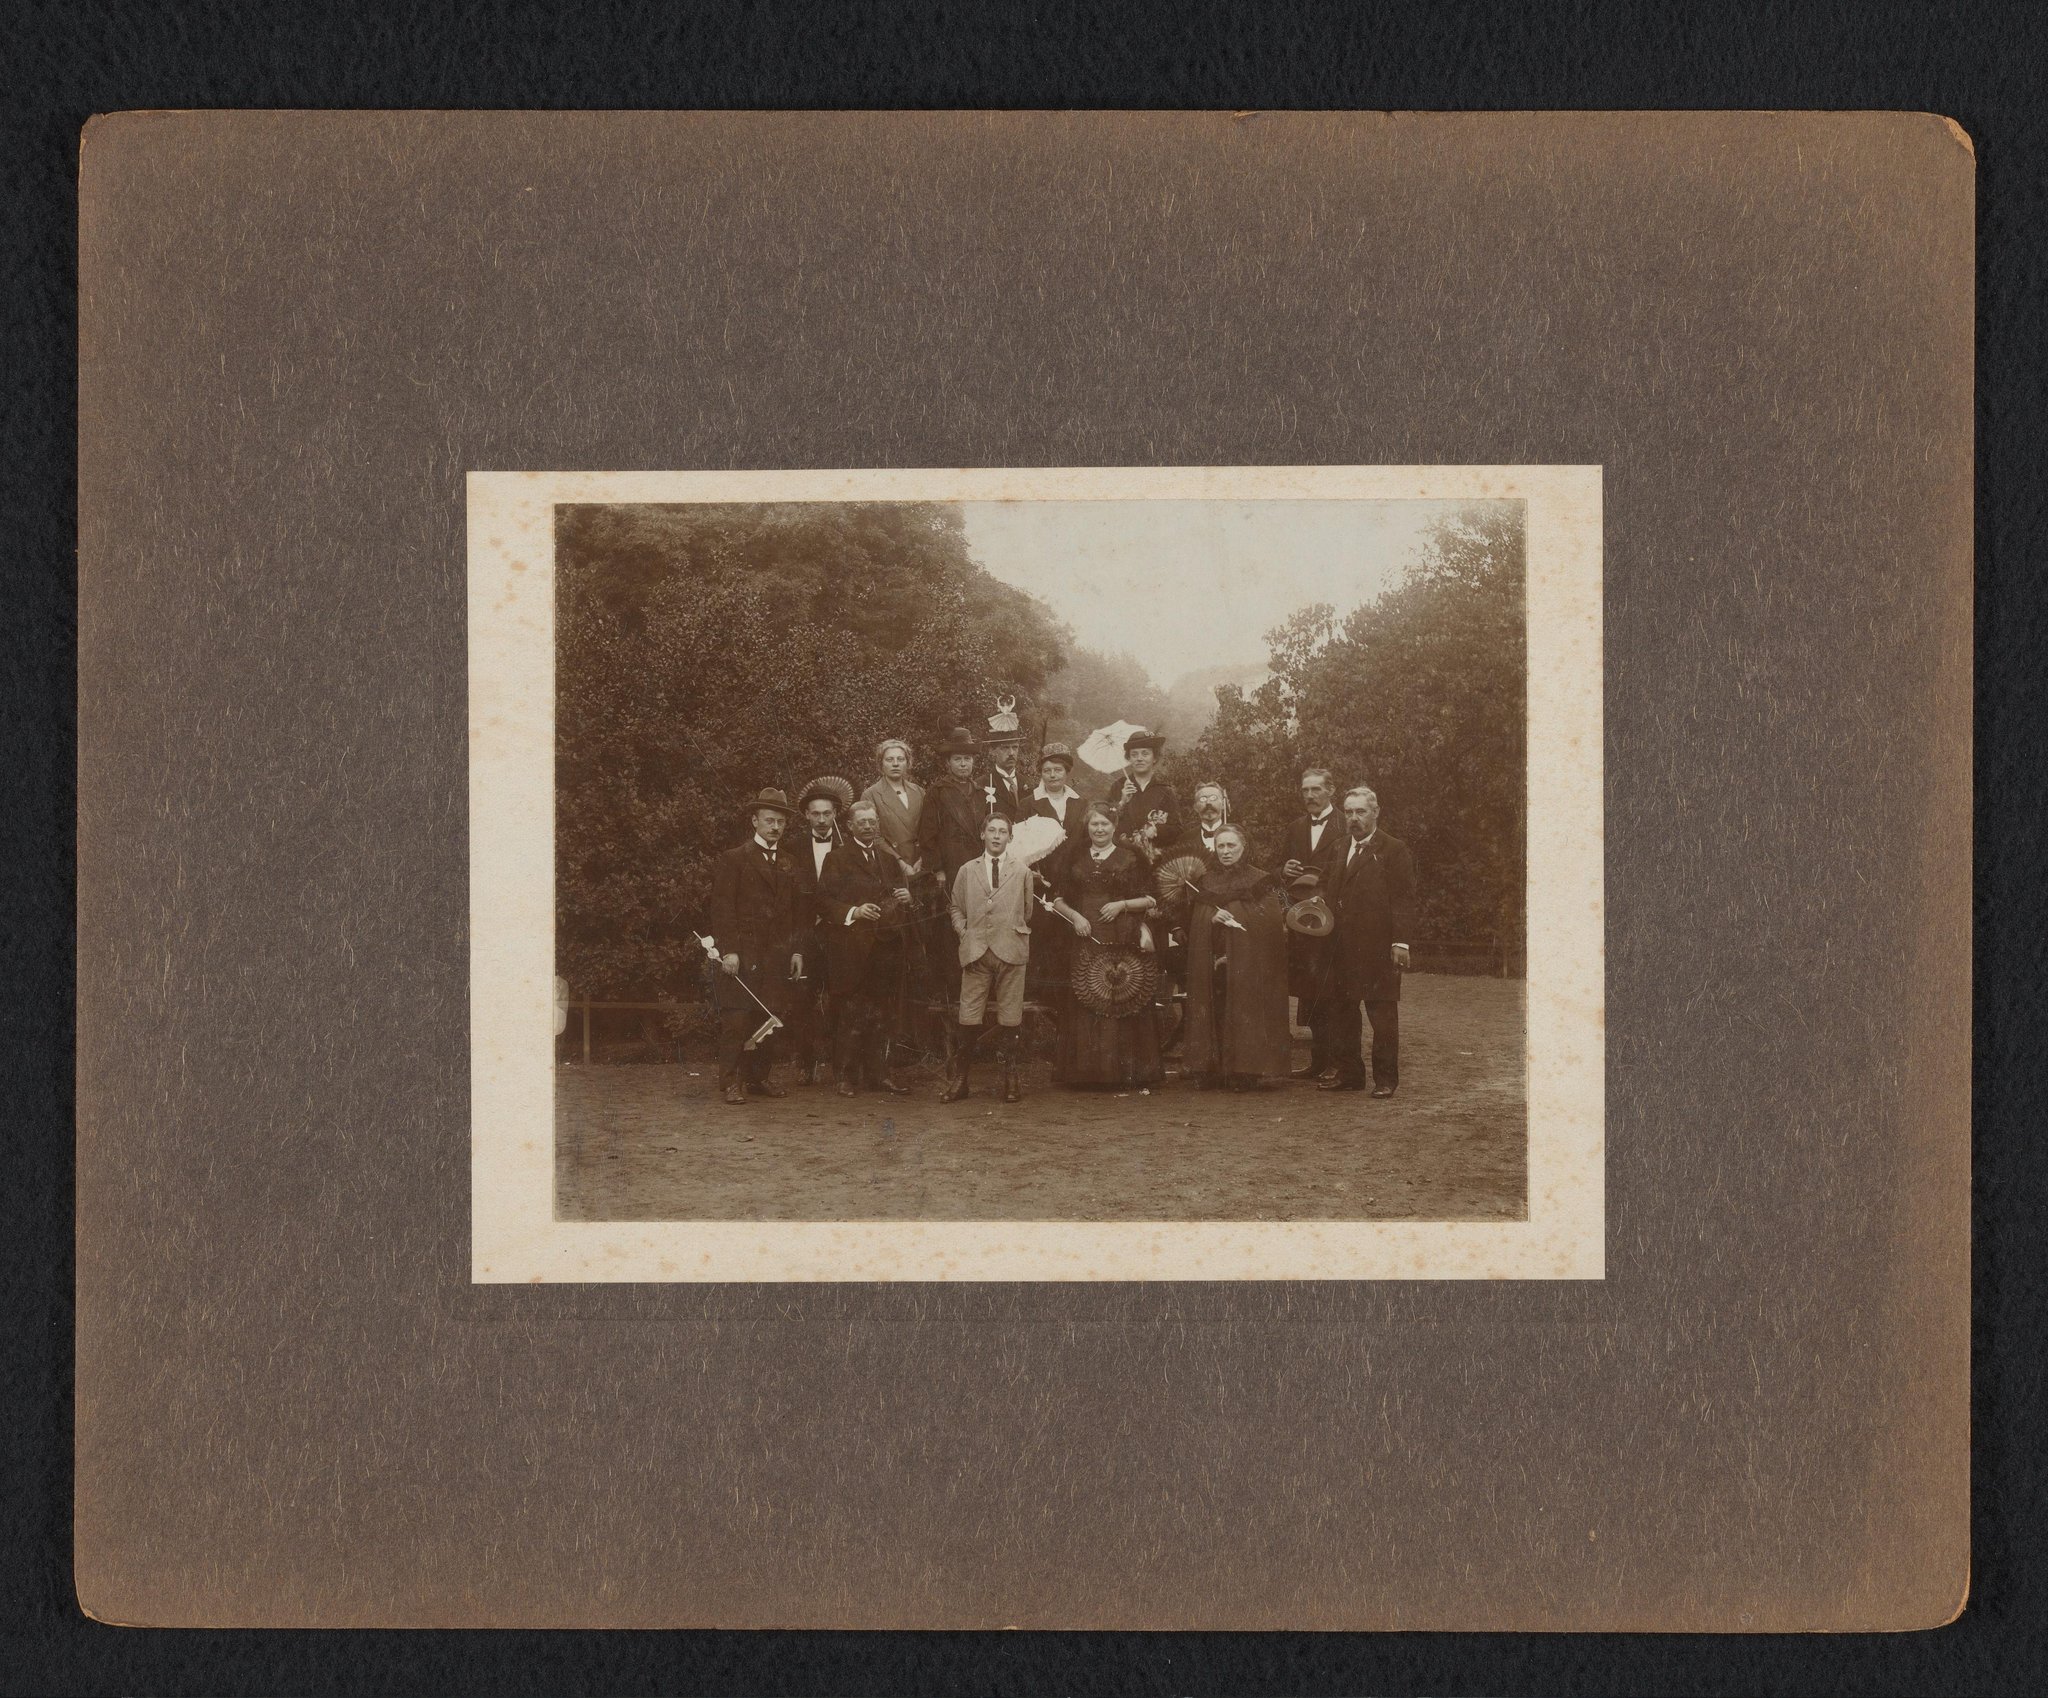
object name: photograph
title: Groepsportret met veertien onbekende personen met feestelijke attributen, mogelijk met Machiel G. G. Suyver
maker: Anonymous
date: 1890-1898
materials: paper, cardboard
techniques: gelatin silver print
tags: machiel gerrit george suyver, festivities, anonymous historical persons portrayed in a group, in a group-portrait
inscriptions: inscription: ‘G. D. Sa[...]/ Photograaf’, address: ‘Lu[...] 103 III’